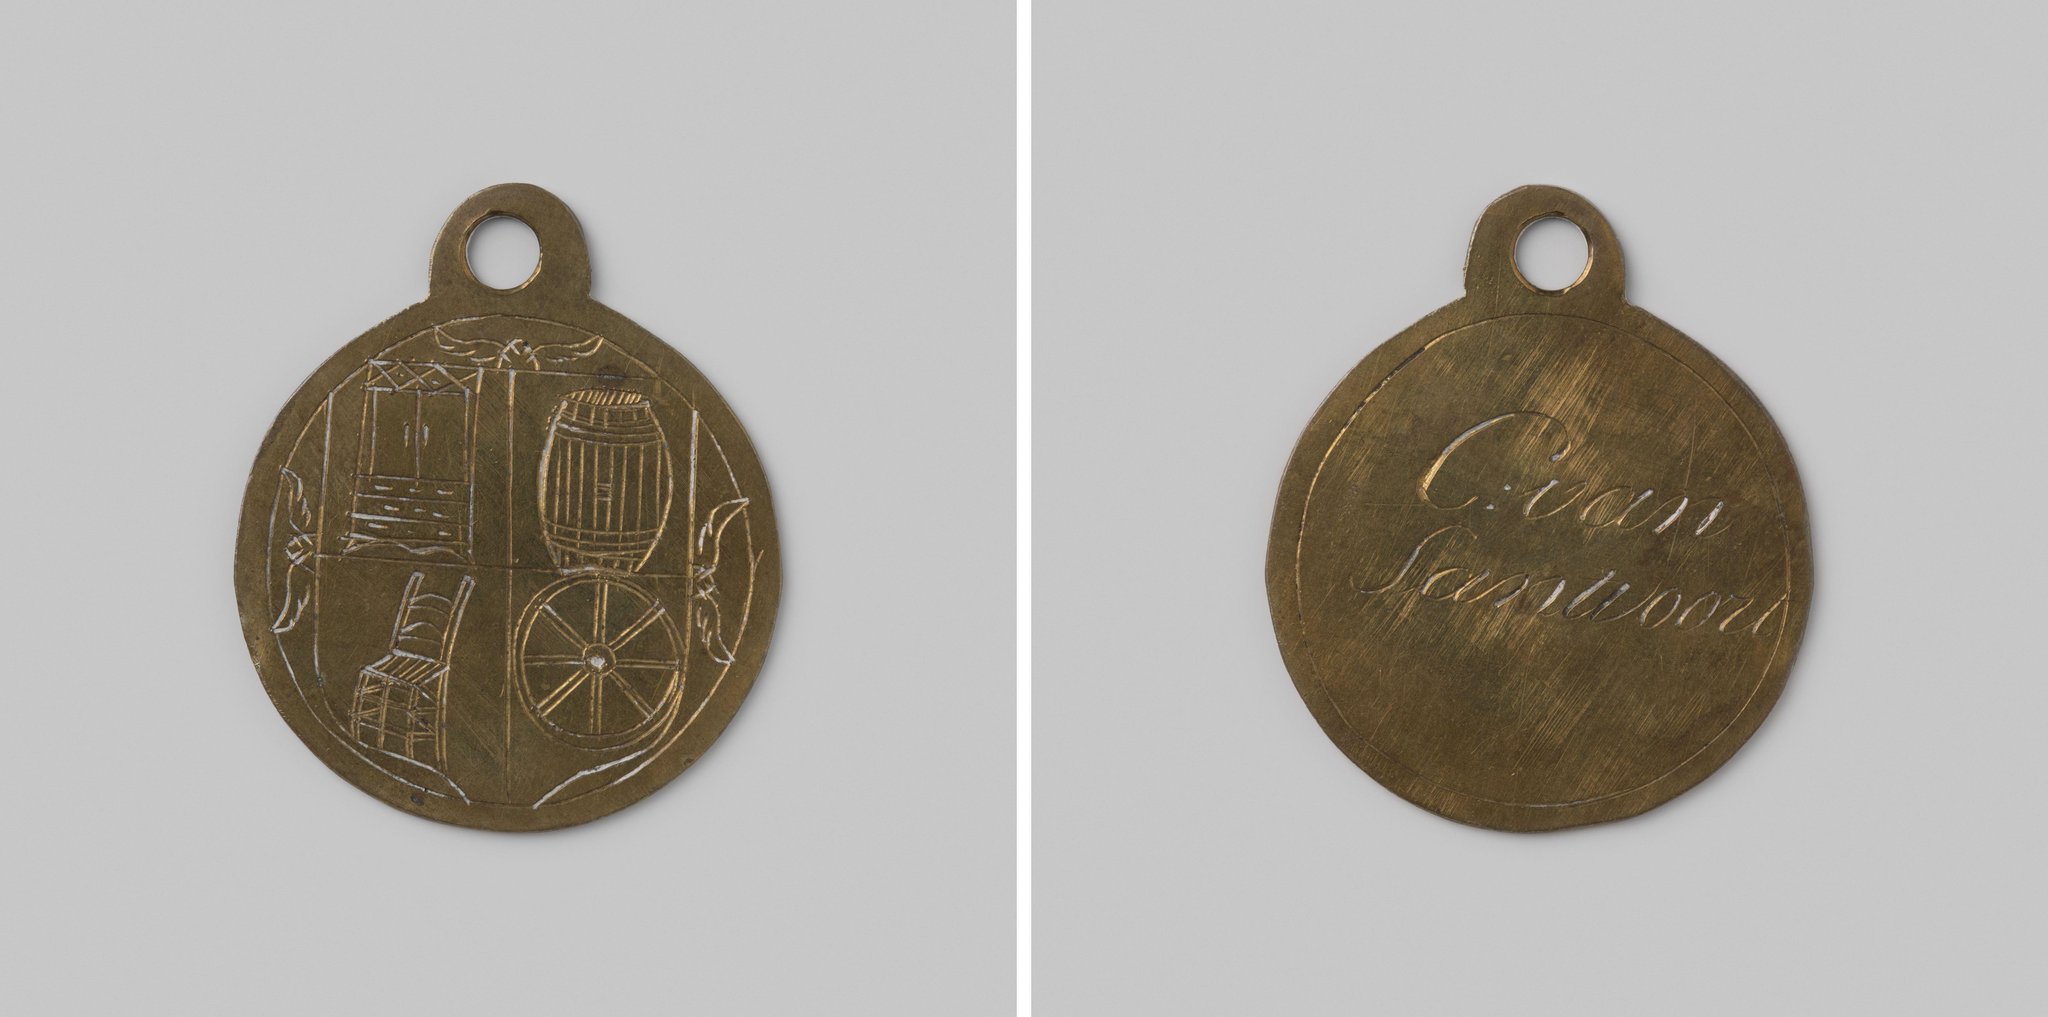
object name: history medal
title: Presentiepenning van het Rademakers-, Kuipers-, Draaiers- en Schrtijnwerkersgilde te 's-Hertogenbosch 1664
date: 1664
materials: brass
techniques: engraving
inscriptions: inscription: ‘C: van / Santvoort’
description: Rond messing plaatje, gegraveerd op de voorzijde een wapenschild met kast, ton, stoel en wiel, op de keerzijde de naam C. van Santvoort, met draagoog